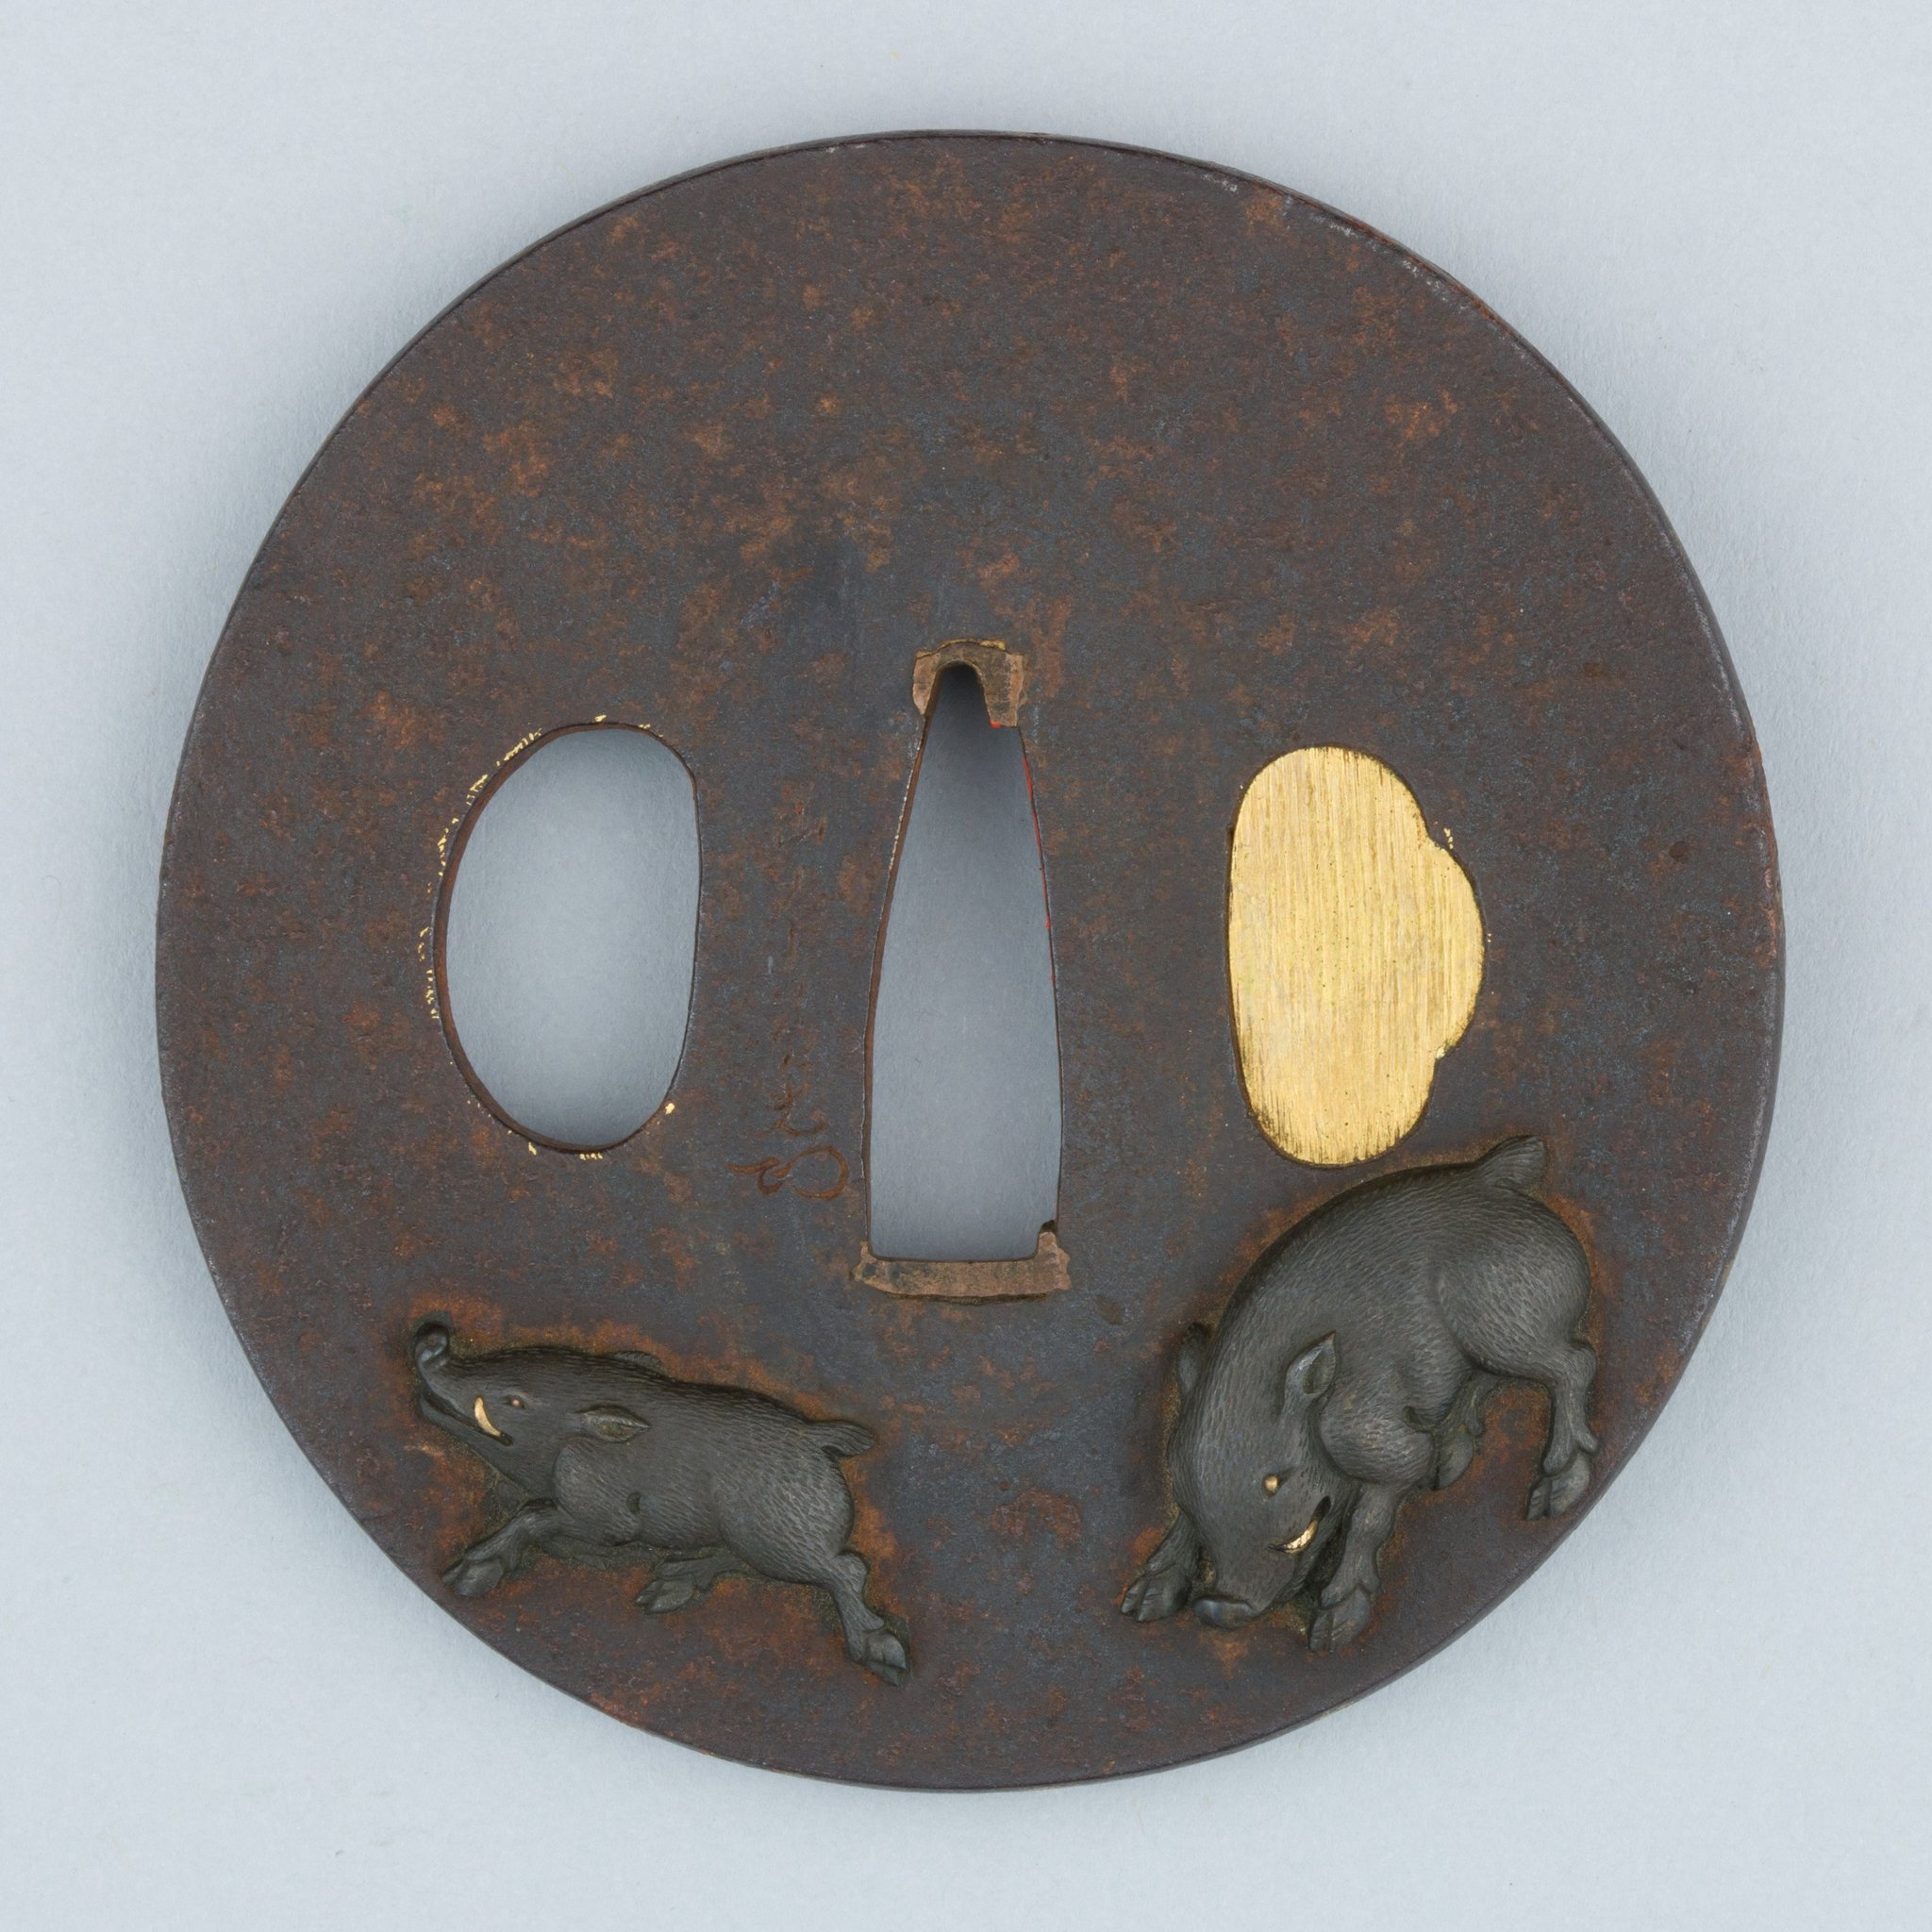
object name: sword guard tsuba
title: Sword Guard (Tsuba)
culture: japanese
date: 1615-1868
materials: copper, silver alloy, iron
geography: japan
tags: boars